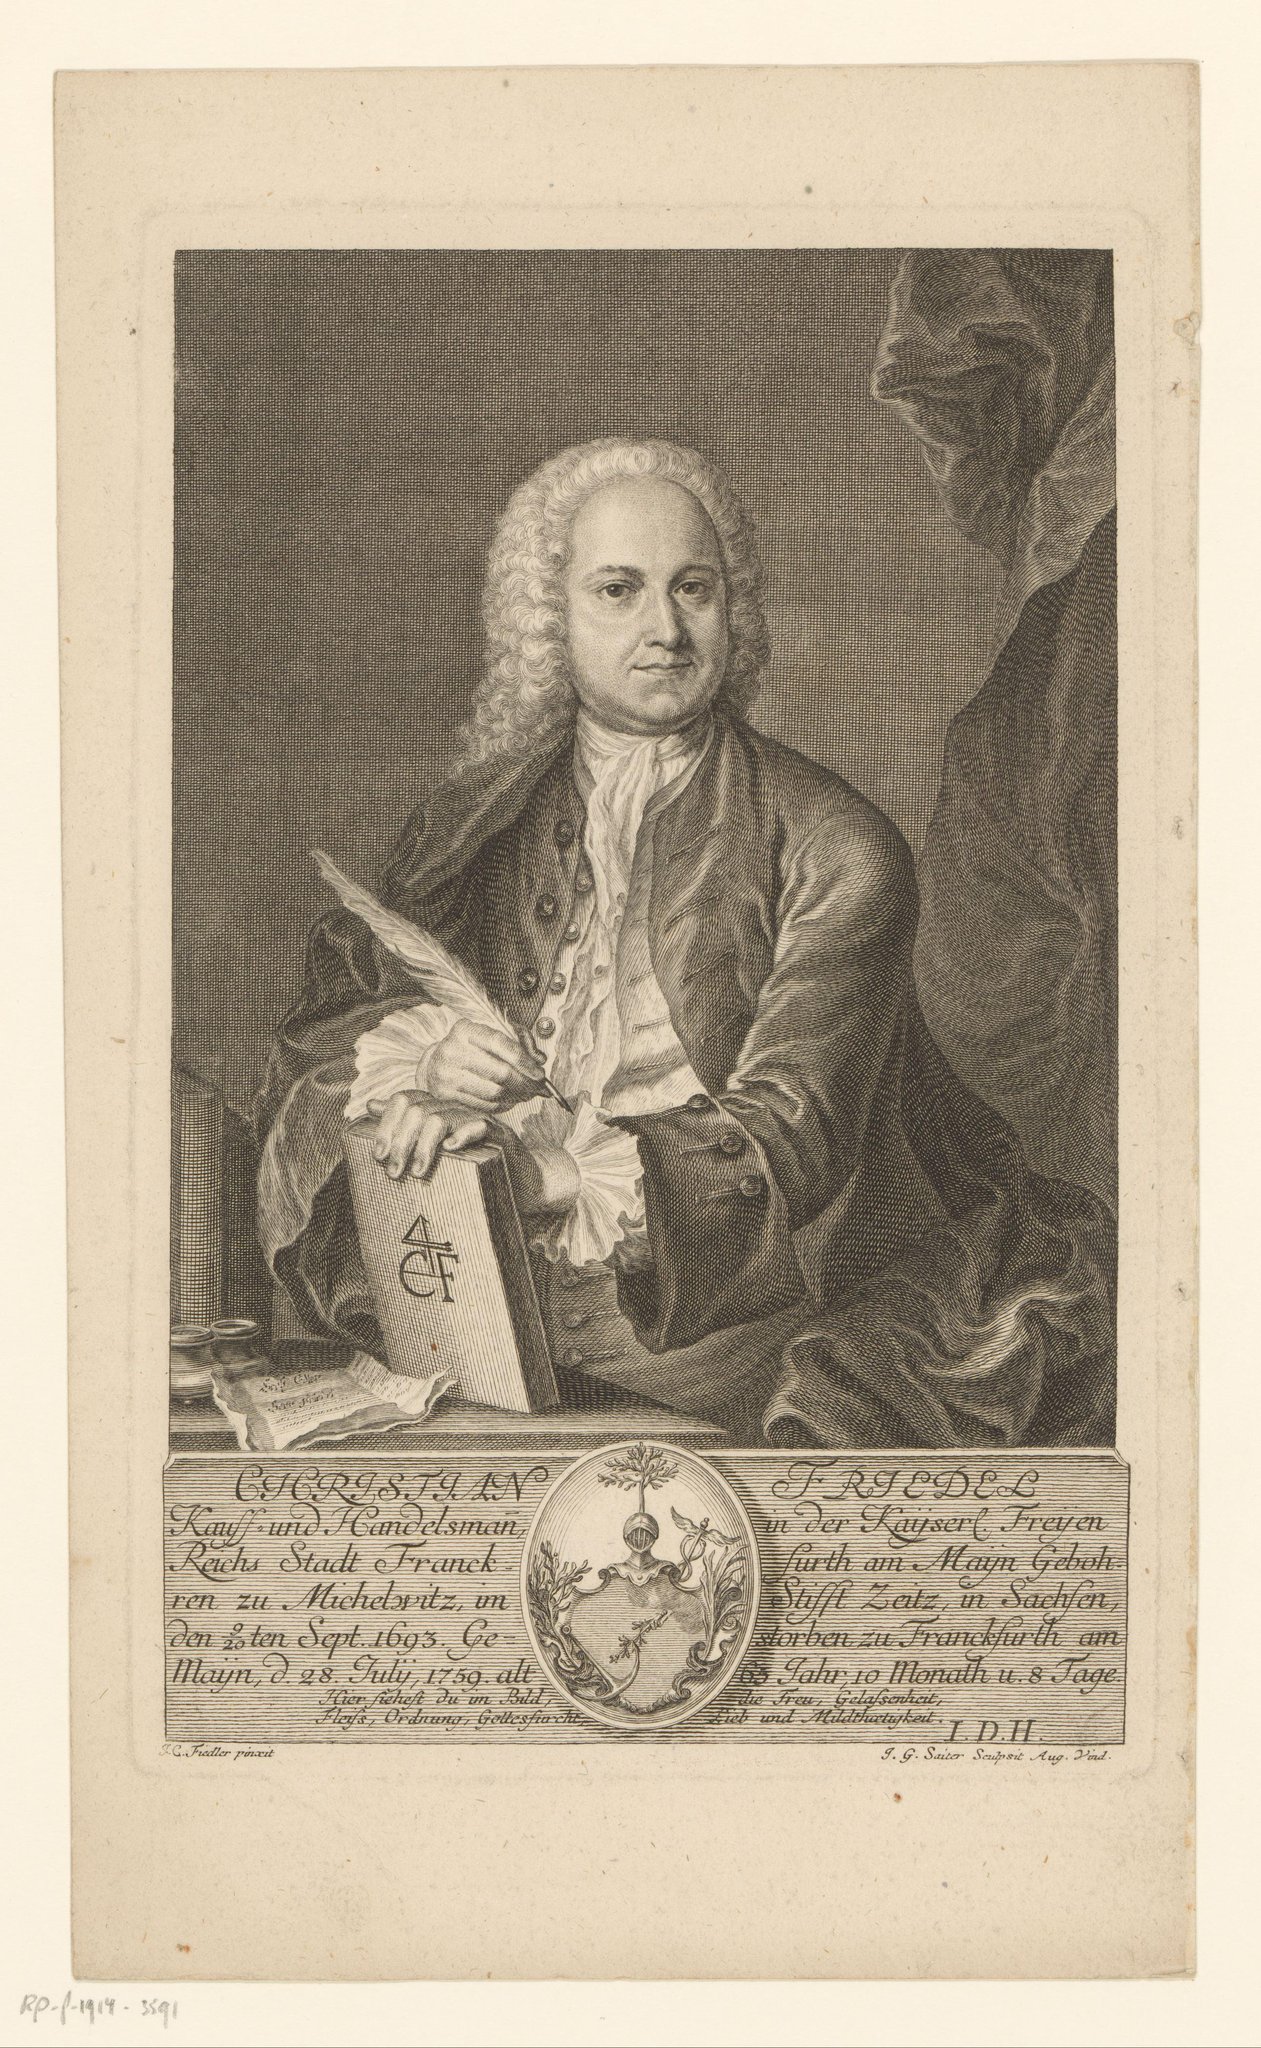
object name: print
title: Portret van Christian Friedel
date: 1759-1800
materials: paper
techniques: engraving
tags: historical persons, writing accessories, armorial bearing, heraldry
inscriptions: collector's mark: Lugt 2228